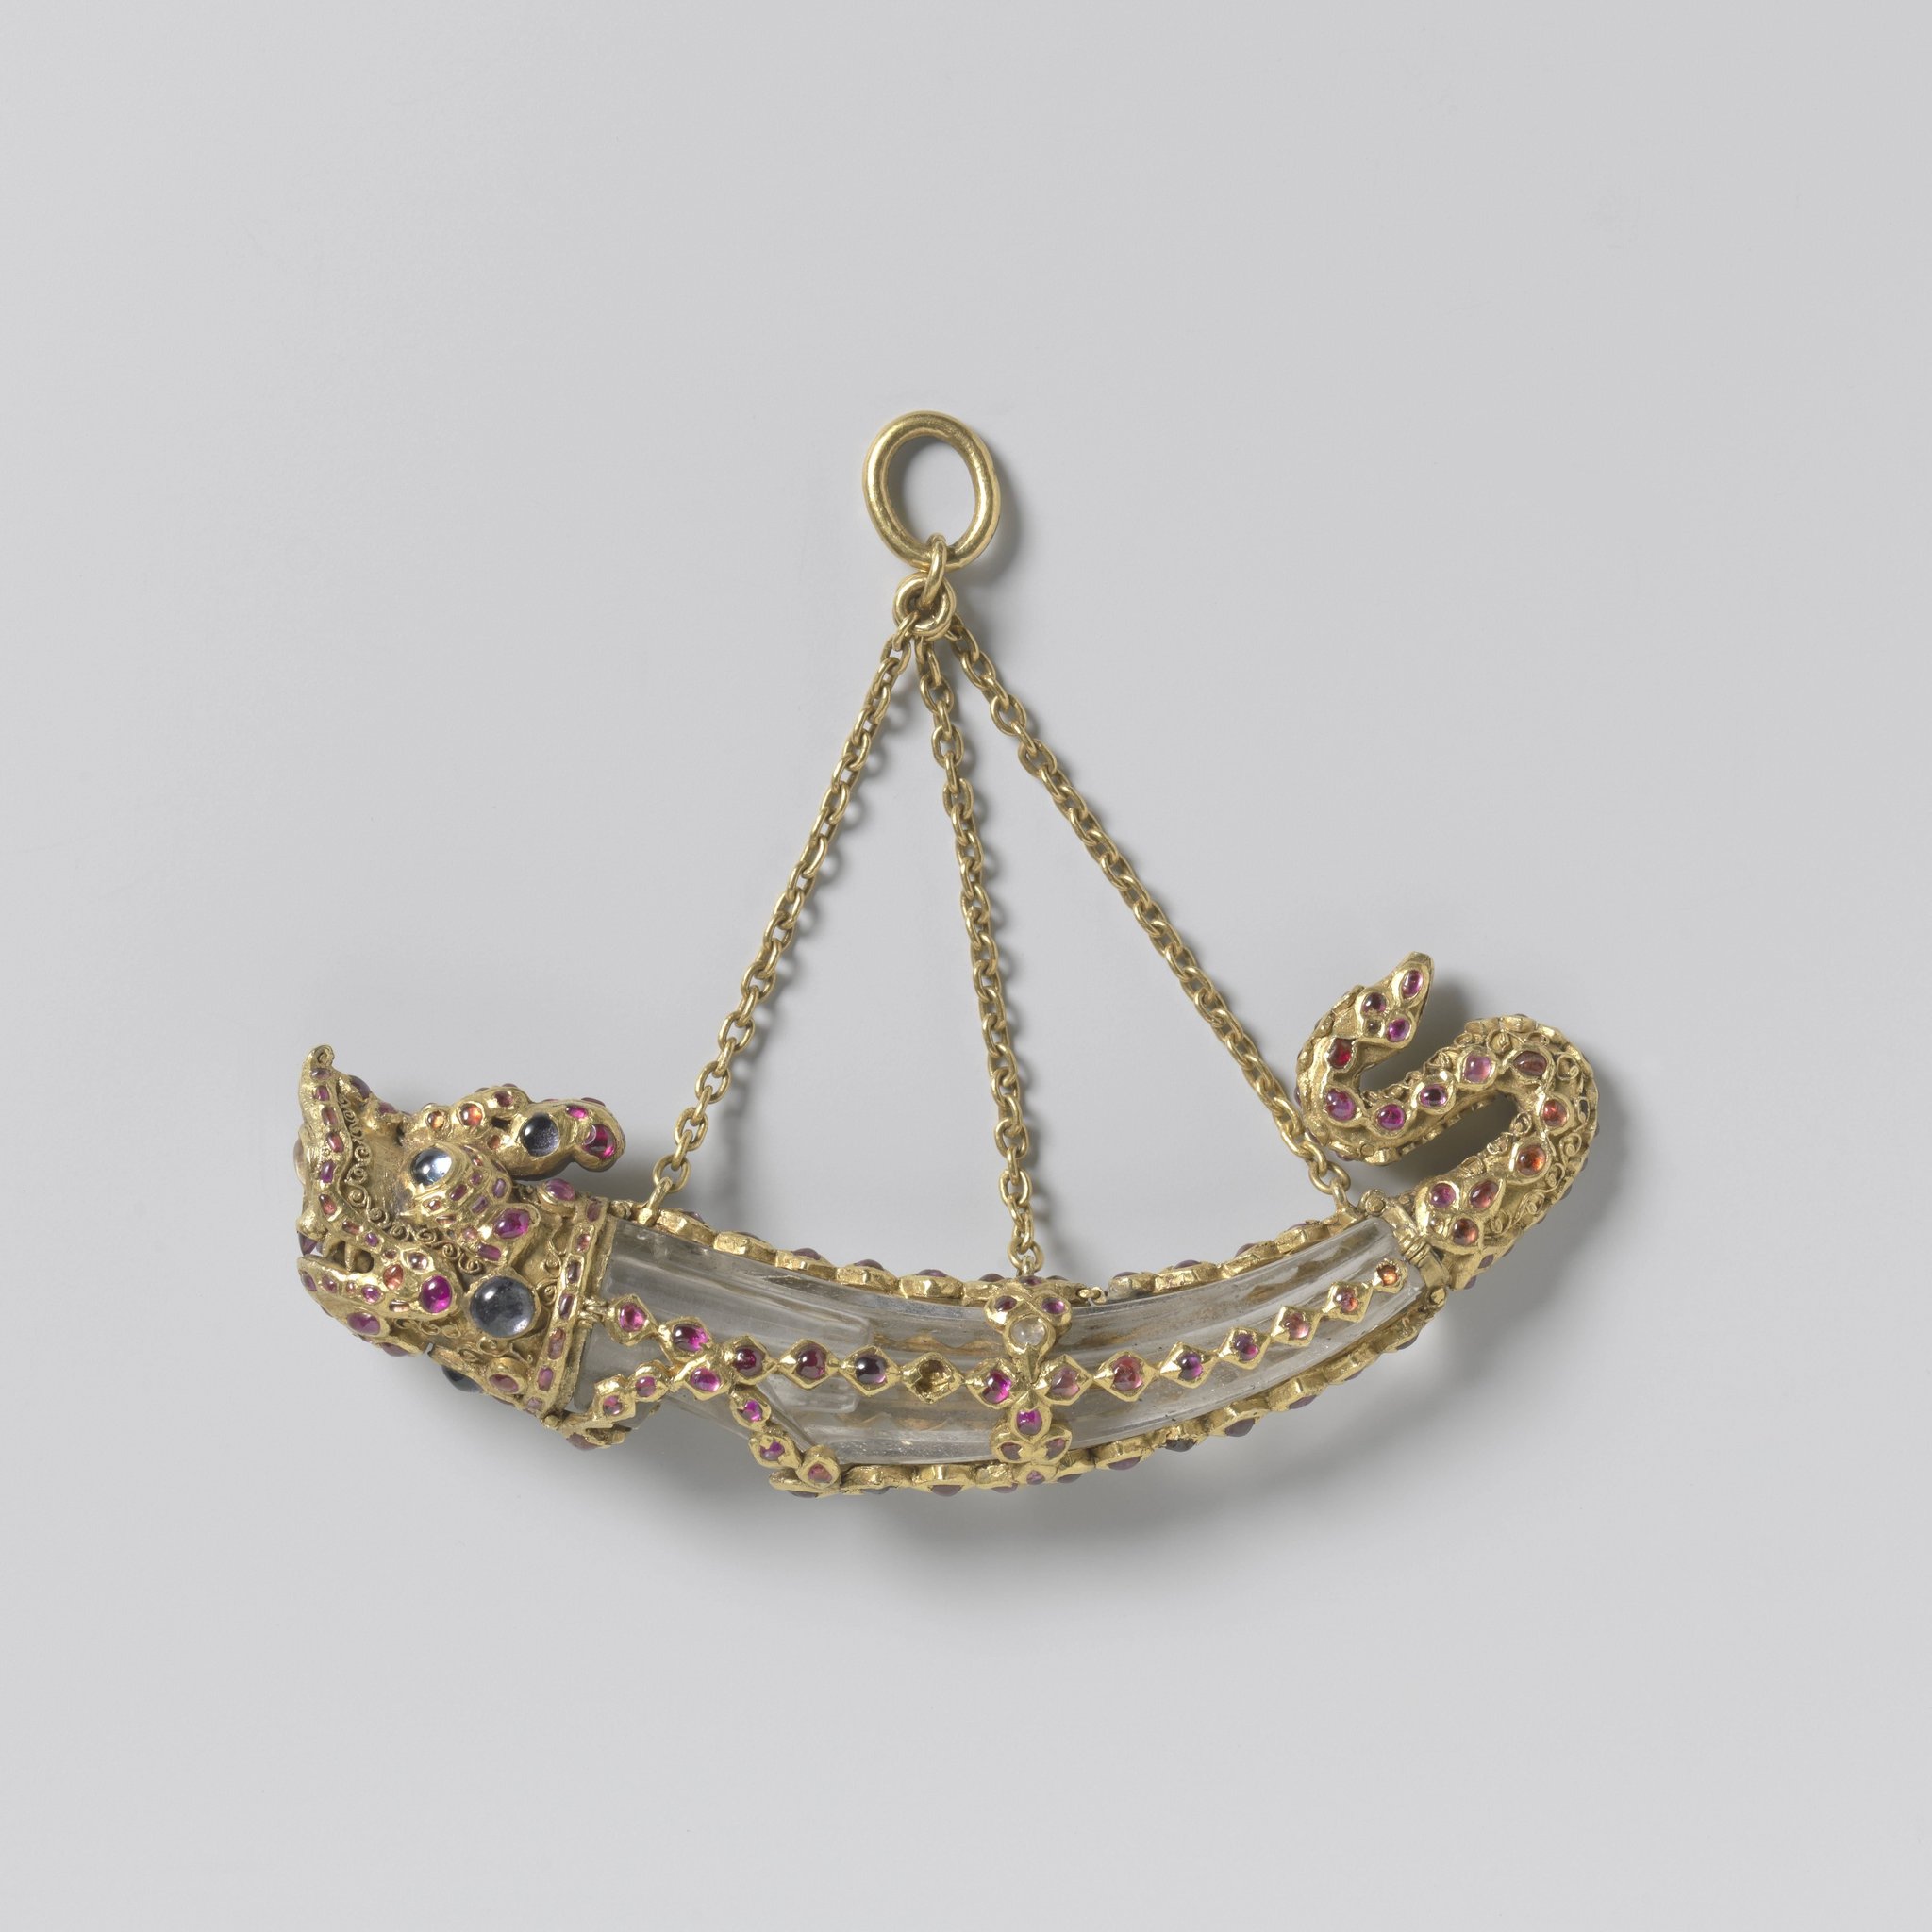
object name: pendant jewelry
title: Makara-shaped Pendant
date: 1600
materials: gold, gemstone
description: This pendant is actually a little whistle: a channel runs through the middle of the creature’s mouth which connects to a notch in the stomach. A whistling noise is created by blowing into the mouth of the water creature (makara). This object, however, was intented primarily as an ornament and was inspired by European whistles made of precious metal that were used by admirals and other naval officers.